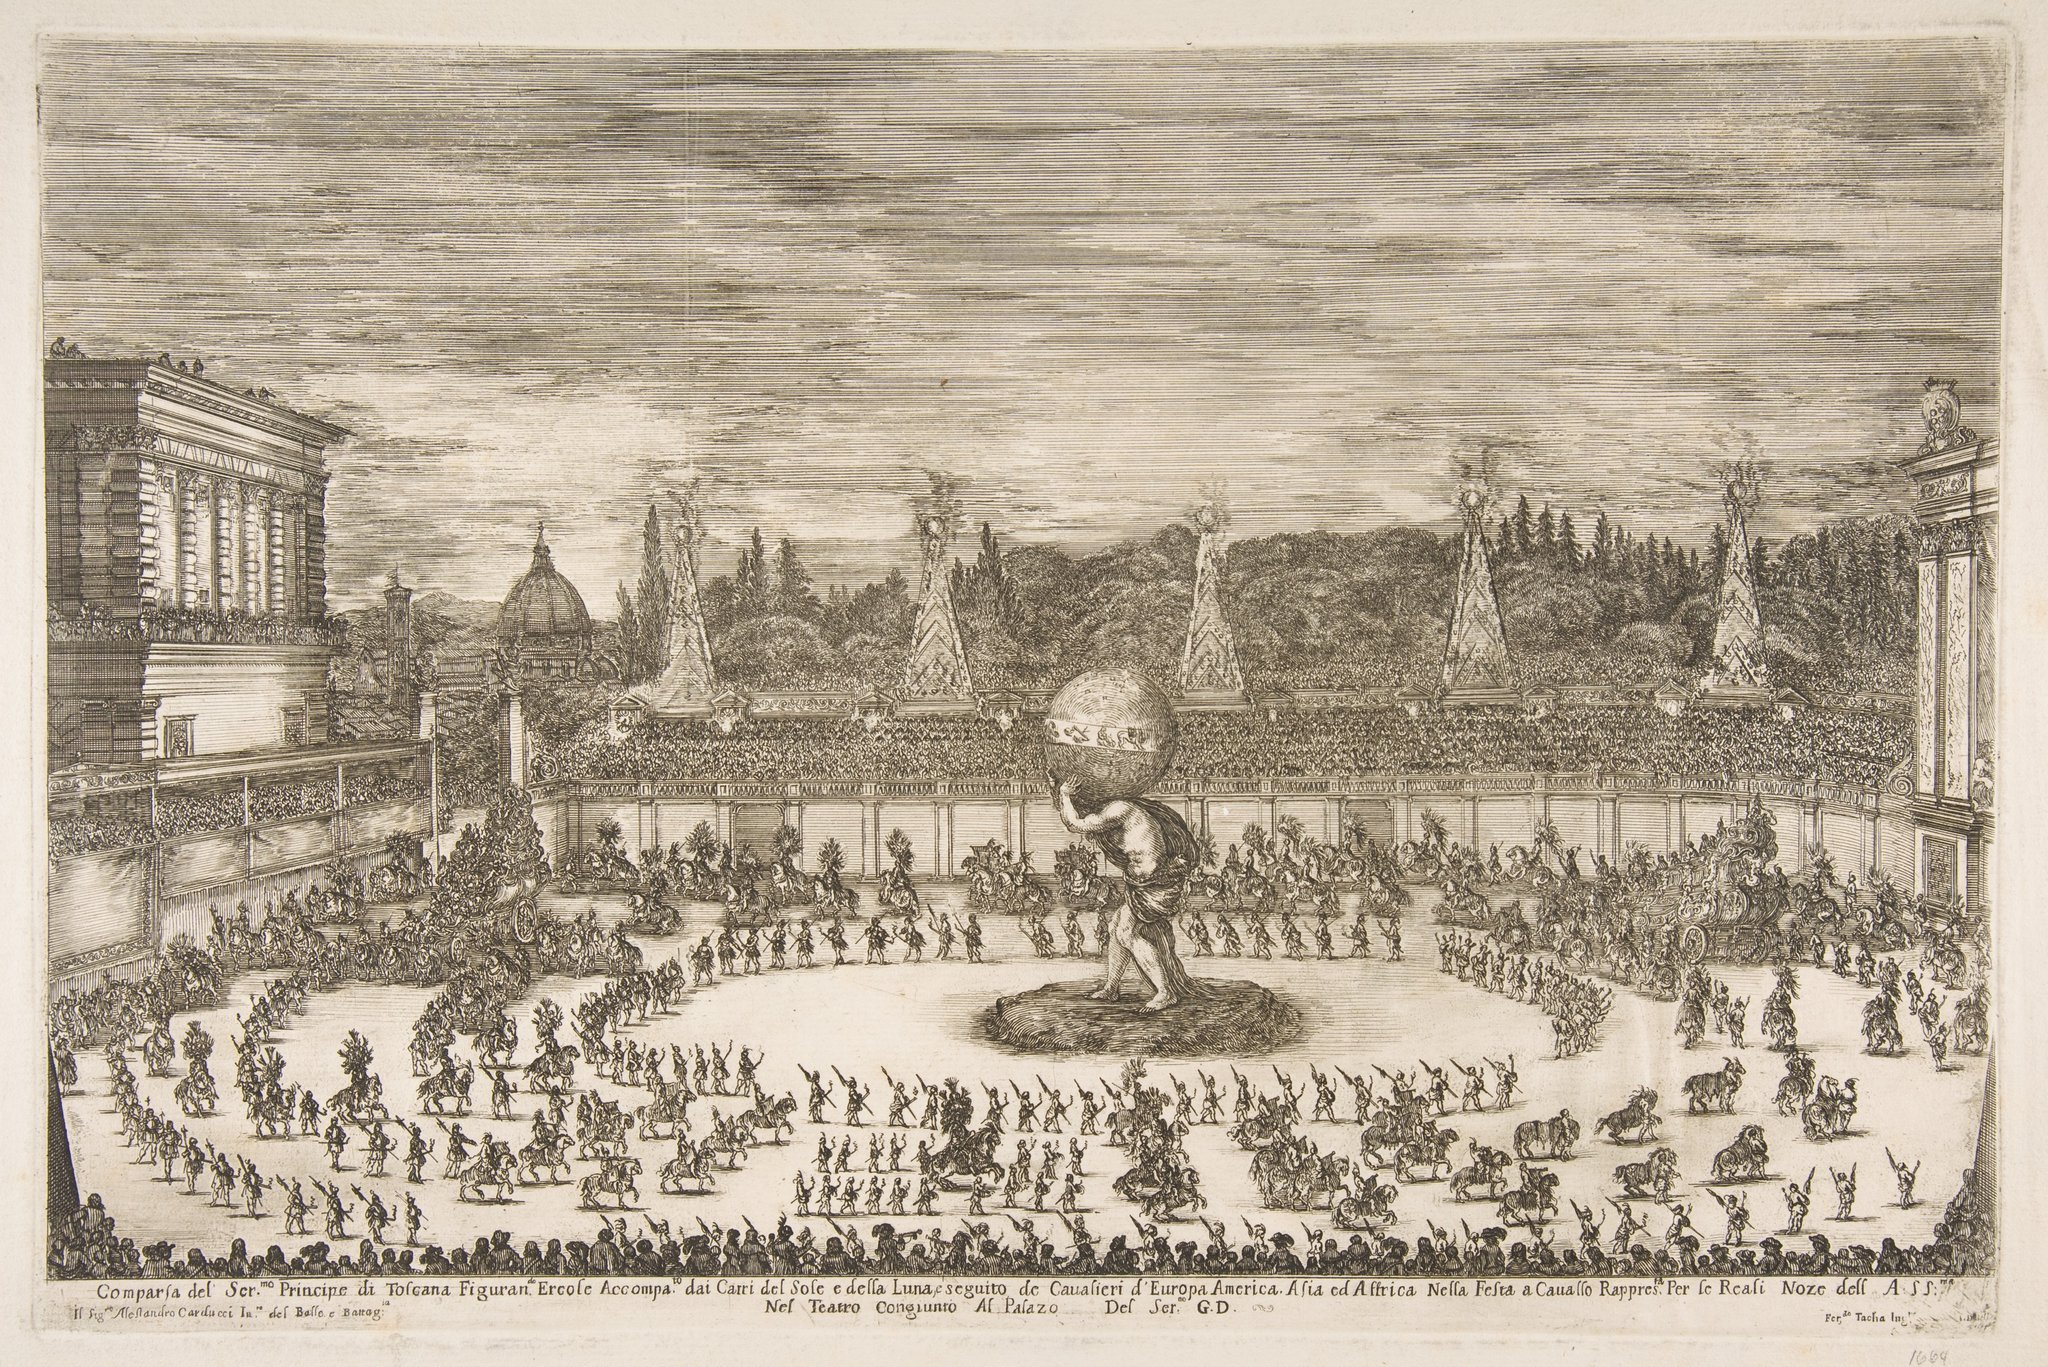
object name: print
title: Il Mondo Festeggiante: Entrance of Cosimo III de' Medici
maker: stefano della bella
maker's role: artist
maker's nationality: italian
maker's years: 1610-1664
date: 1661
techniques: etching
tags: buildings,horses,crowd